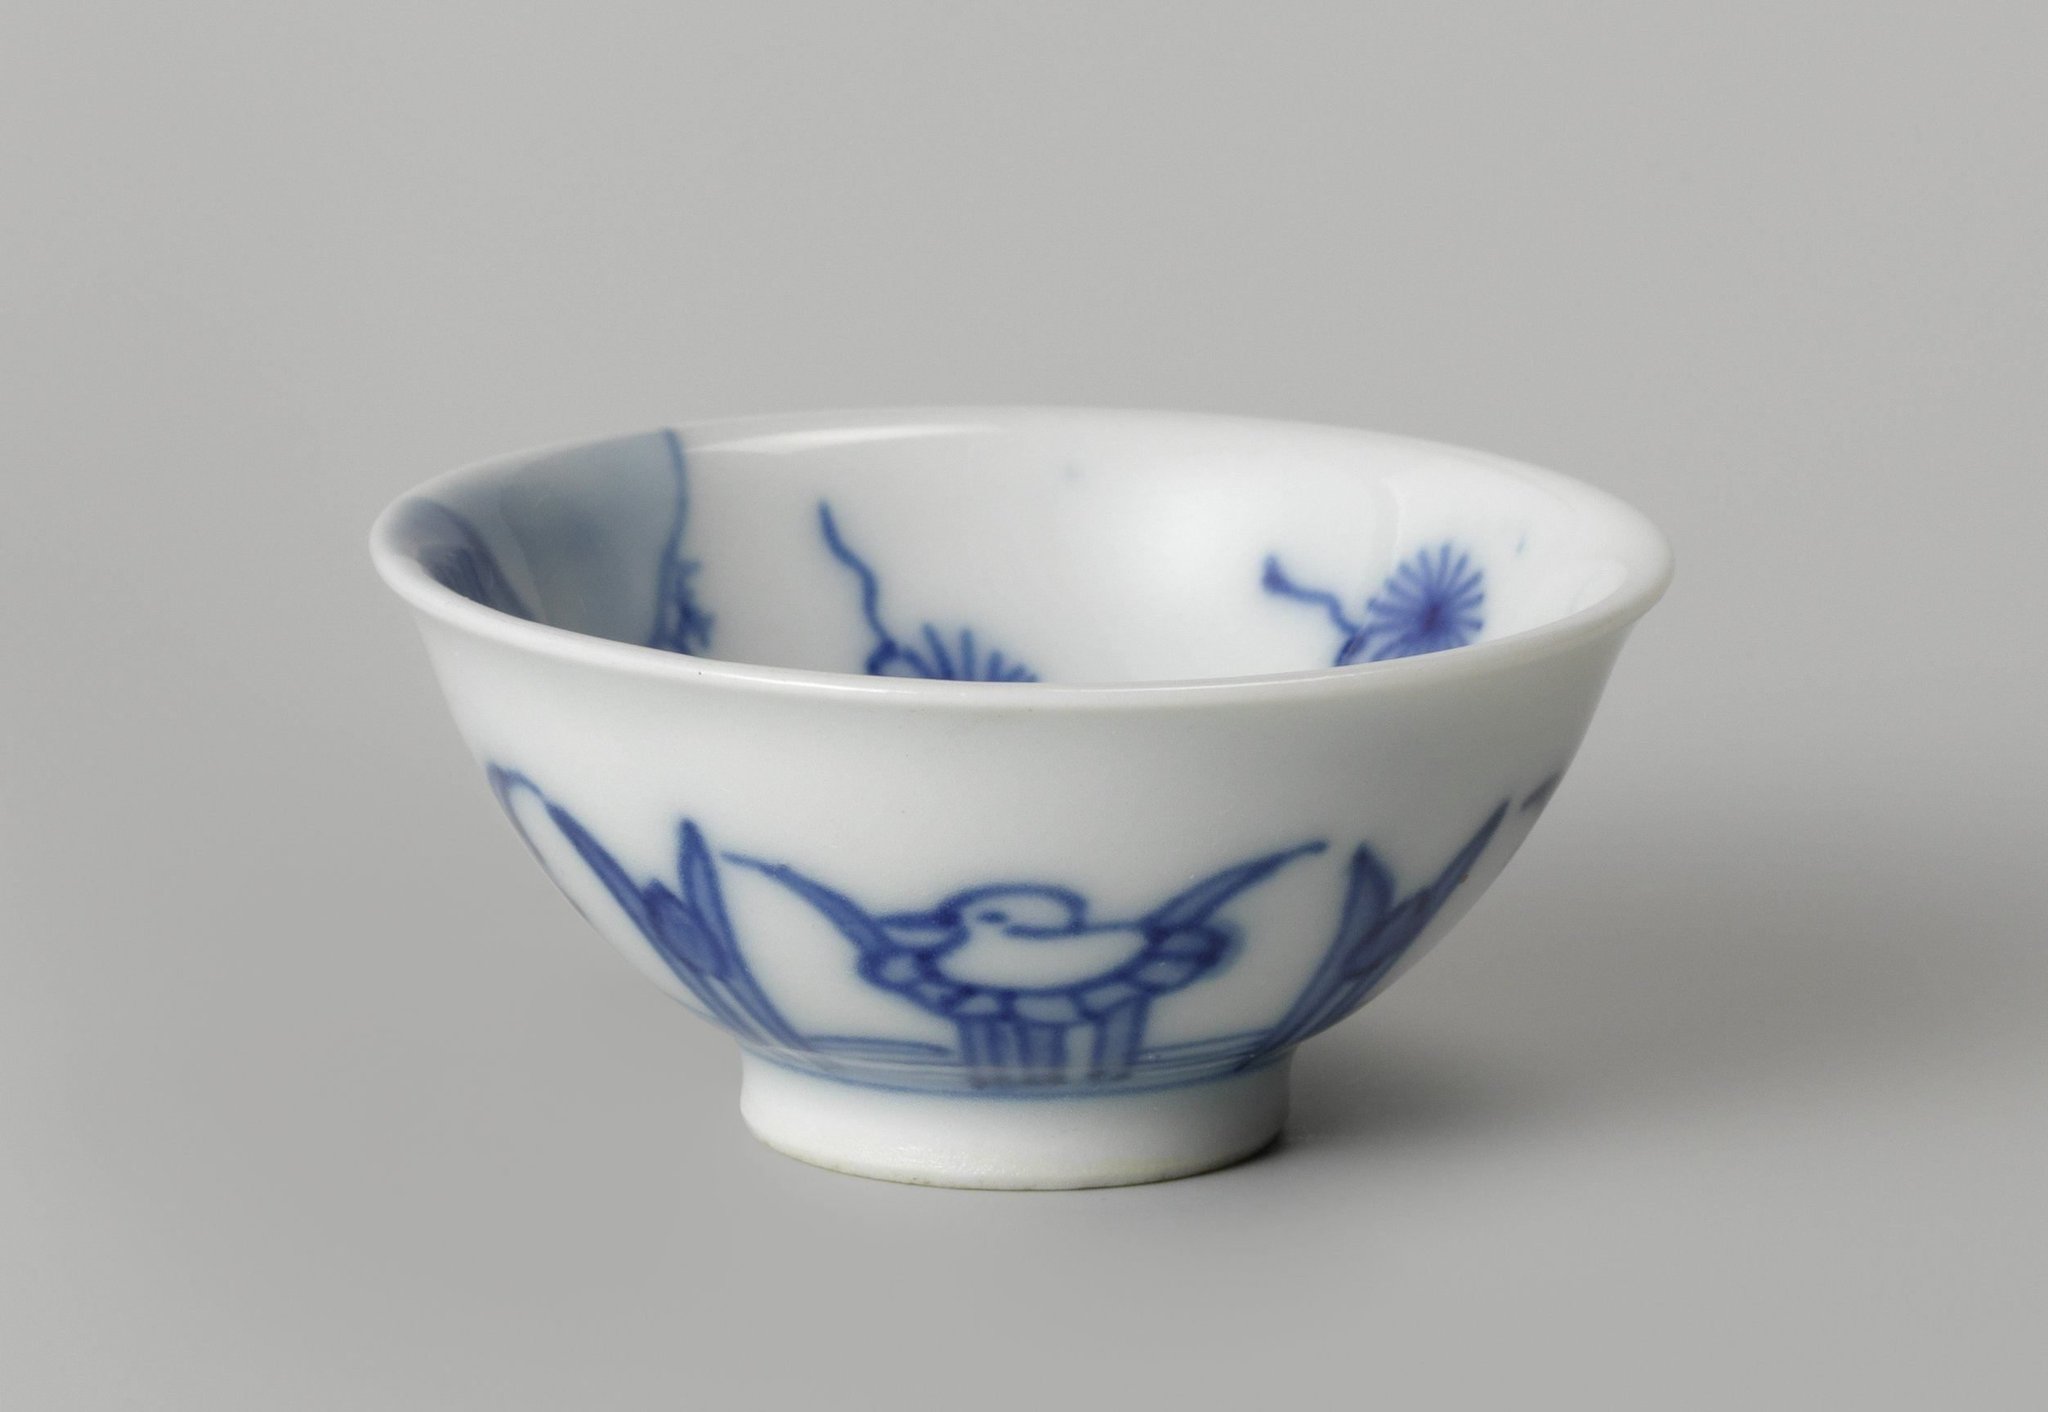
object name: cup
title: Bell-shaped bowl with a water landscape and stylized lotuses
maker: Anonymous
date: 1680-1720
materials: cobalt, glaze, paint, porcelain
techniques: firing, turning, vitrification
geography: china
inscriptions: mark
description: Klokvormige kop van porselein, beschilderd in onderglazuur blauw. Op de buitenwand een doorlopende band met gestileerde lotusplanten met afwisselend een bloem en een vogel op een blad. De binnenzijde met een doorlopend landschap met paviljoens, personen en een pijnboom bij een rots. Gemerkt op de onderzijde met twee ongeïdentificeerde Chinese karakters in een cirkel. Blauw-wit.